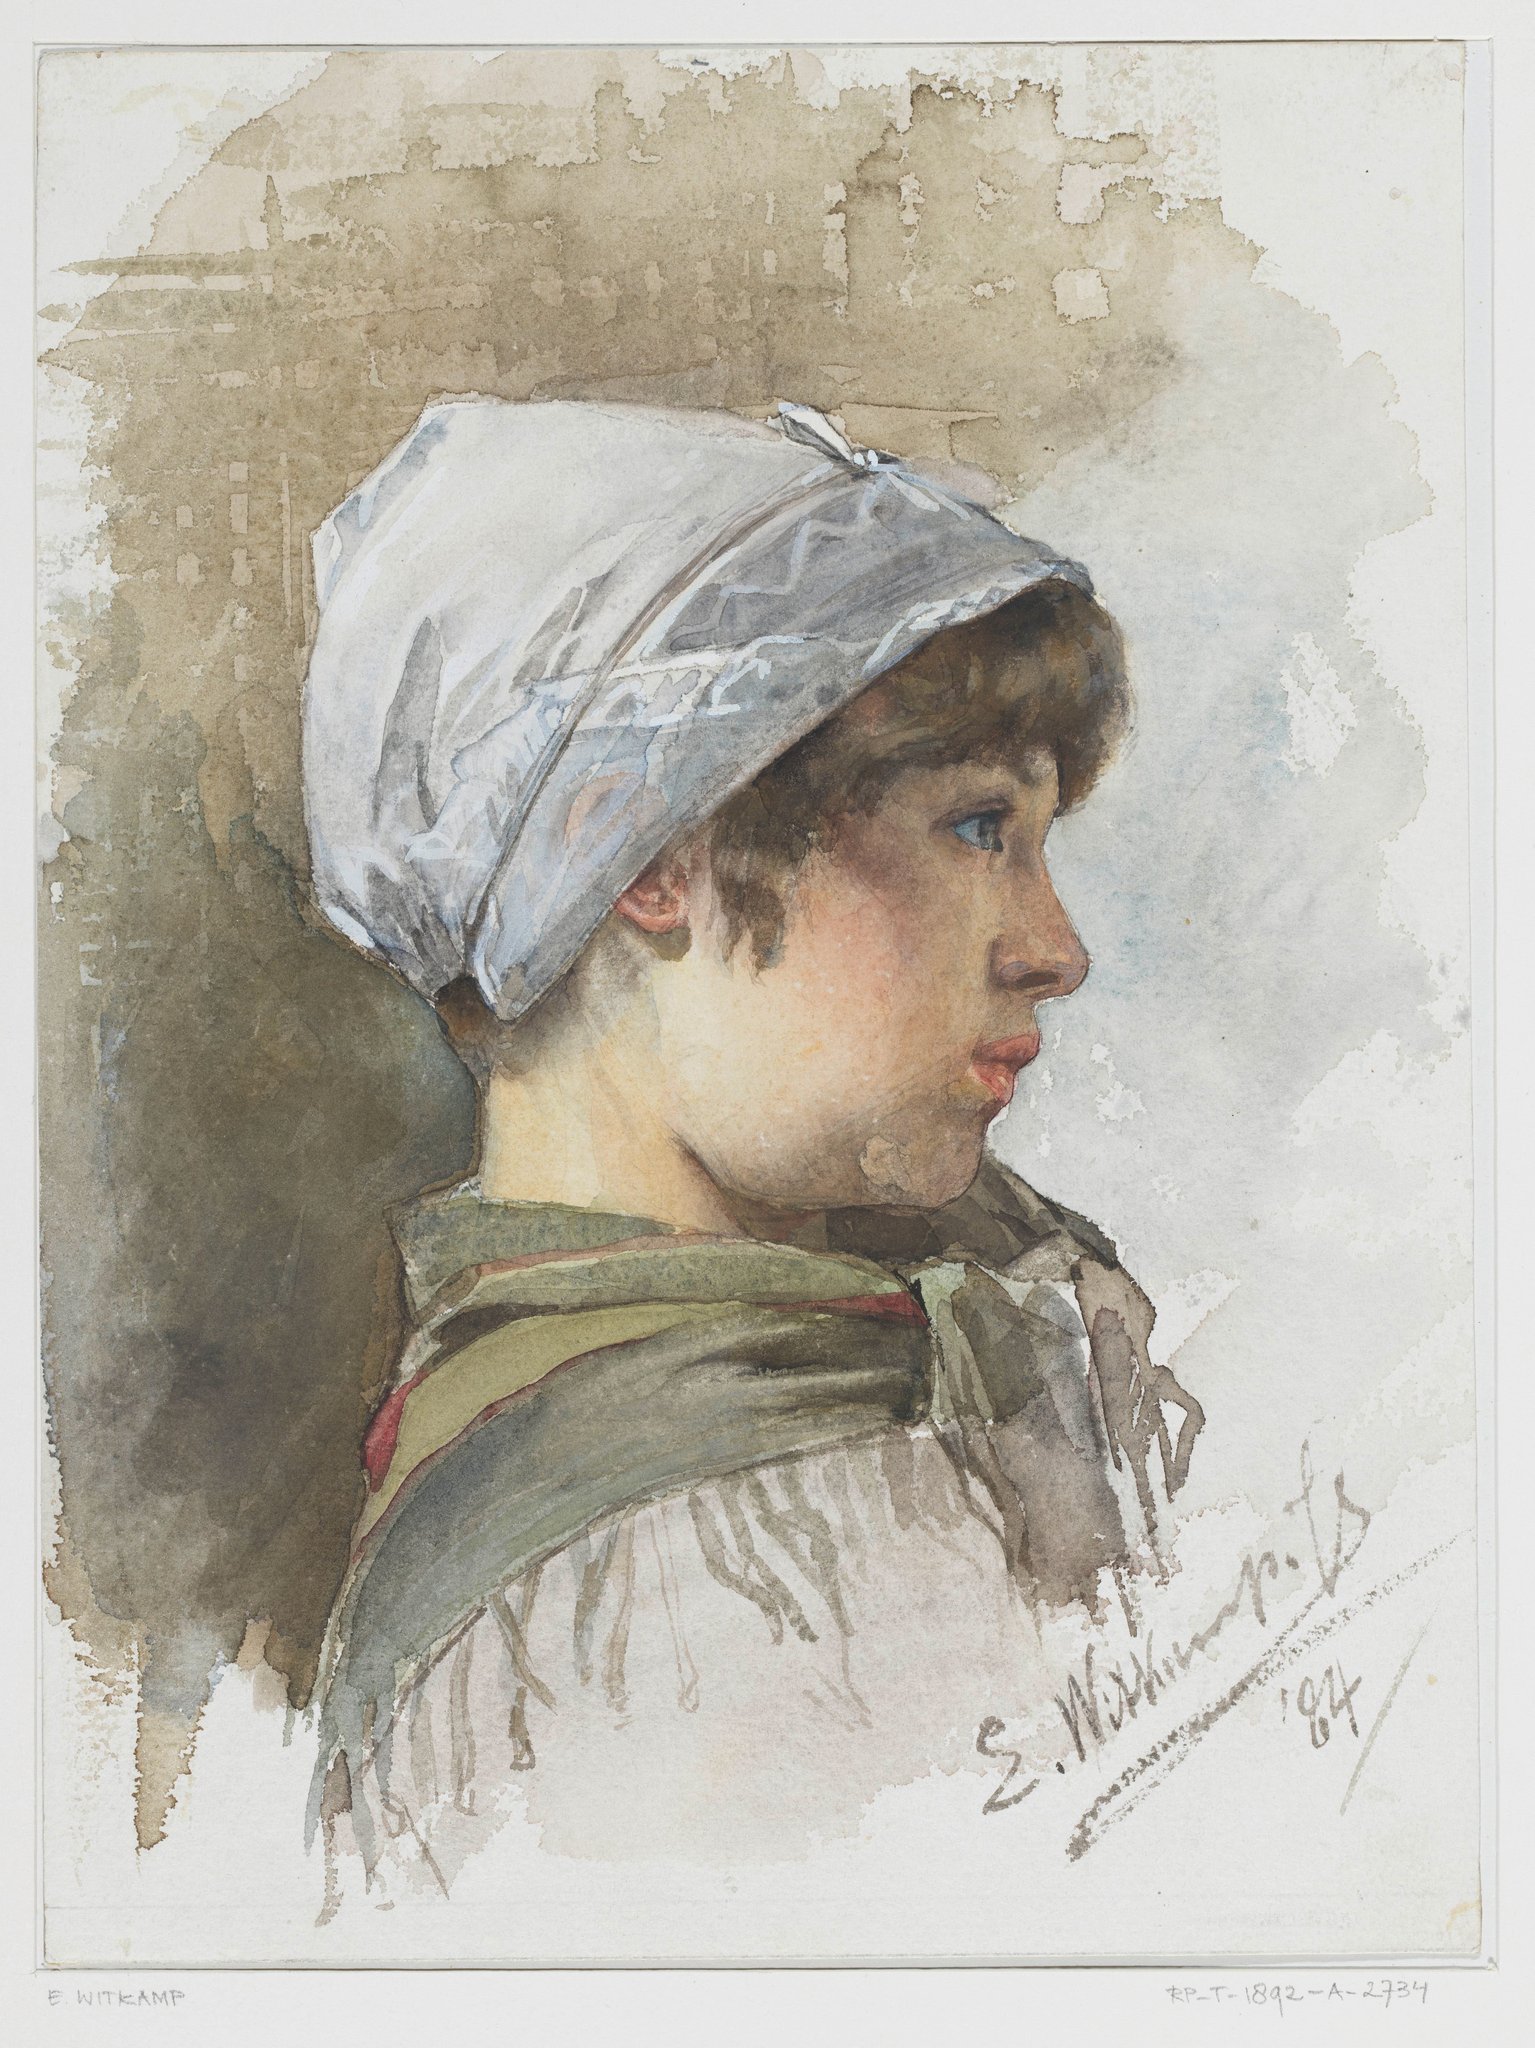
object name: watercolor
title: Studie van het hoofd van een jong meisje, en profil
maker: ernst witkamp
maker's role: draughtsman, print maker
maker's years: 1854-1897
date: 1884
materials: paper, pencil, watercolor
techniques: brush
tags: girl (child between toddler and youth), anonymous historical person portrayed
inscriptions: date: ‘'84’